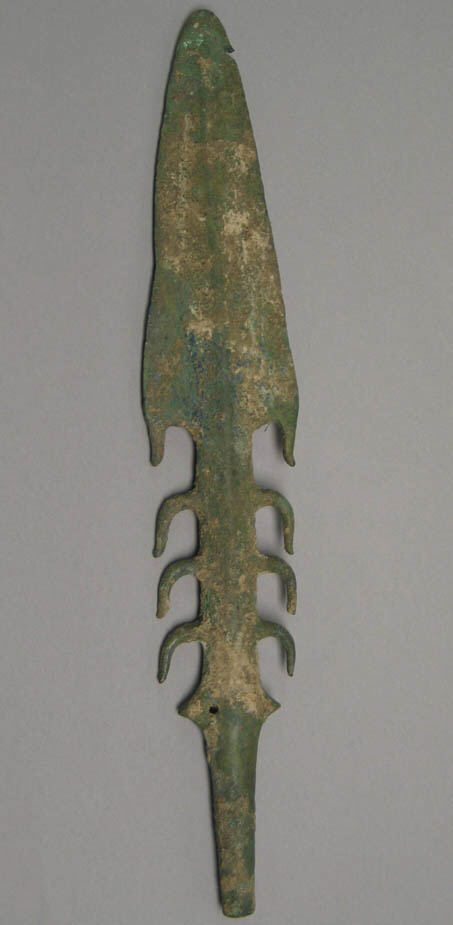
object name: harpoon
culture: indian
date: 1500-500 BCE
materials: copper